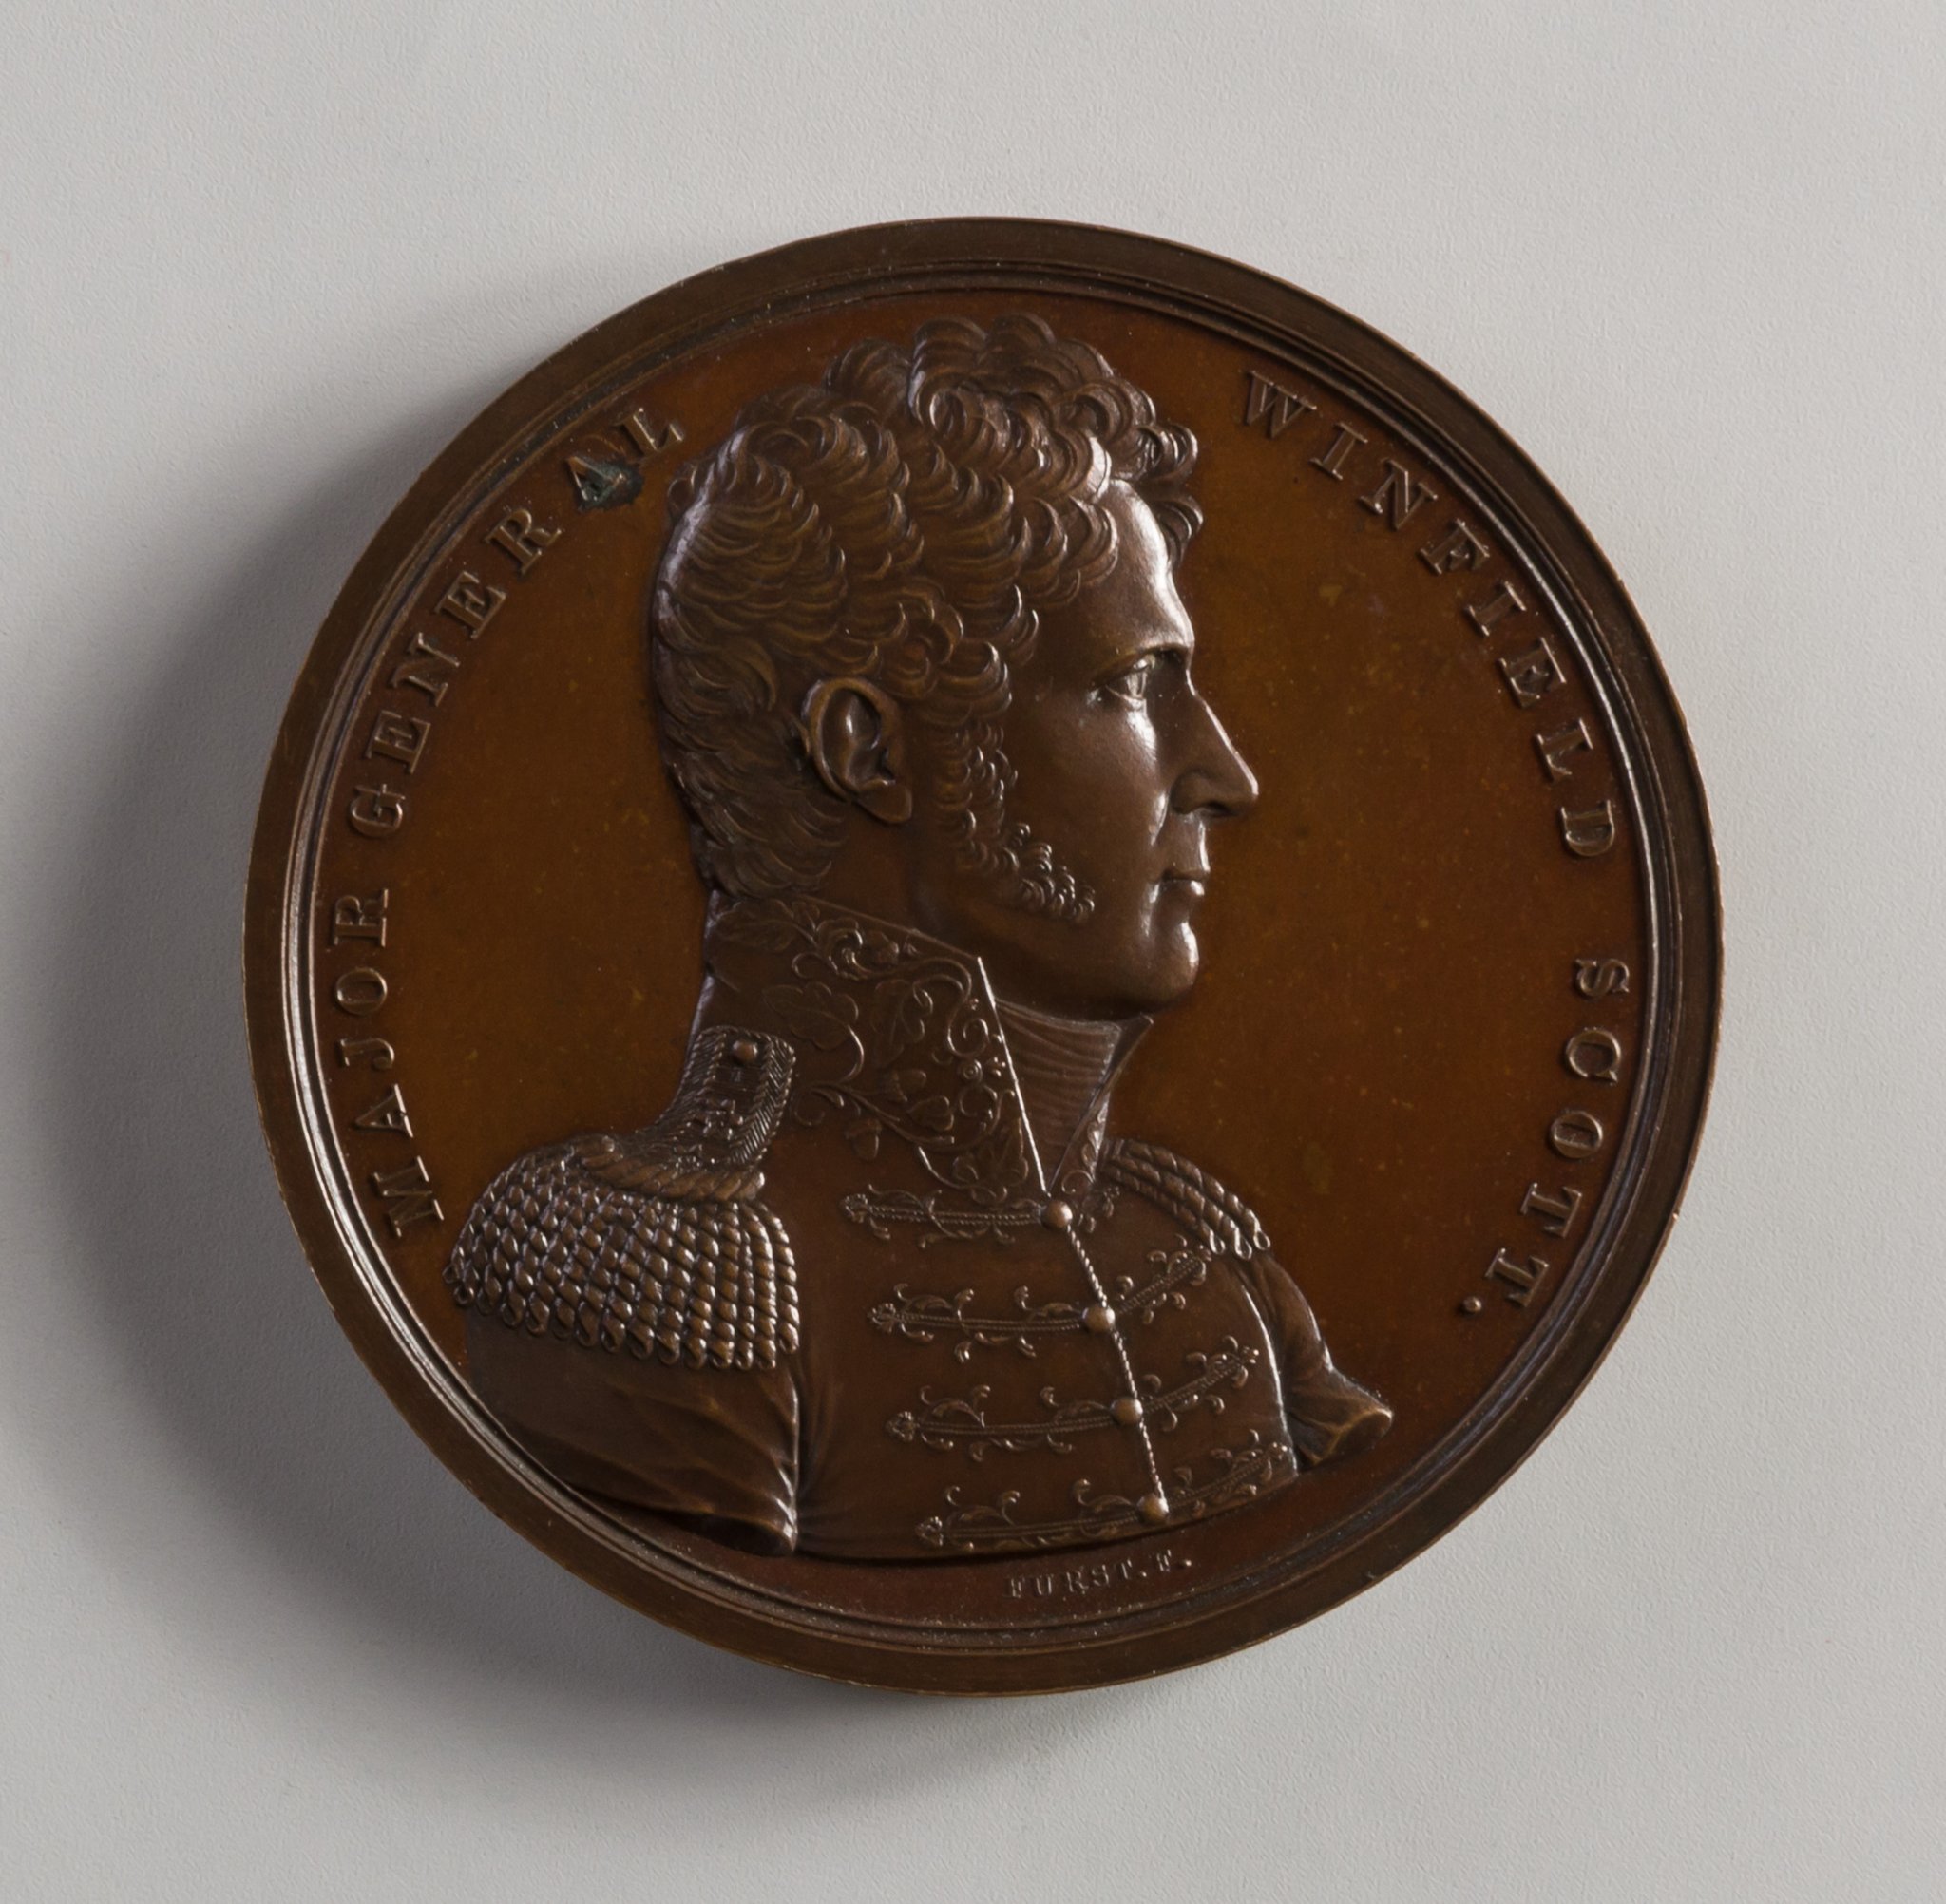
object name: medal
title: Medal of Major General Winfield Scott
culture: american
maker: moritz fürst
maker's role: maker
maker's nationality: hungarian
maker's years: 1782-1882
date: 1818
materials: bronze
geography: united states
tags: men,profiles